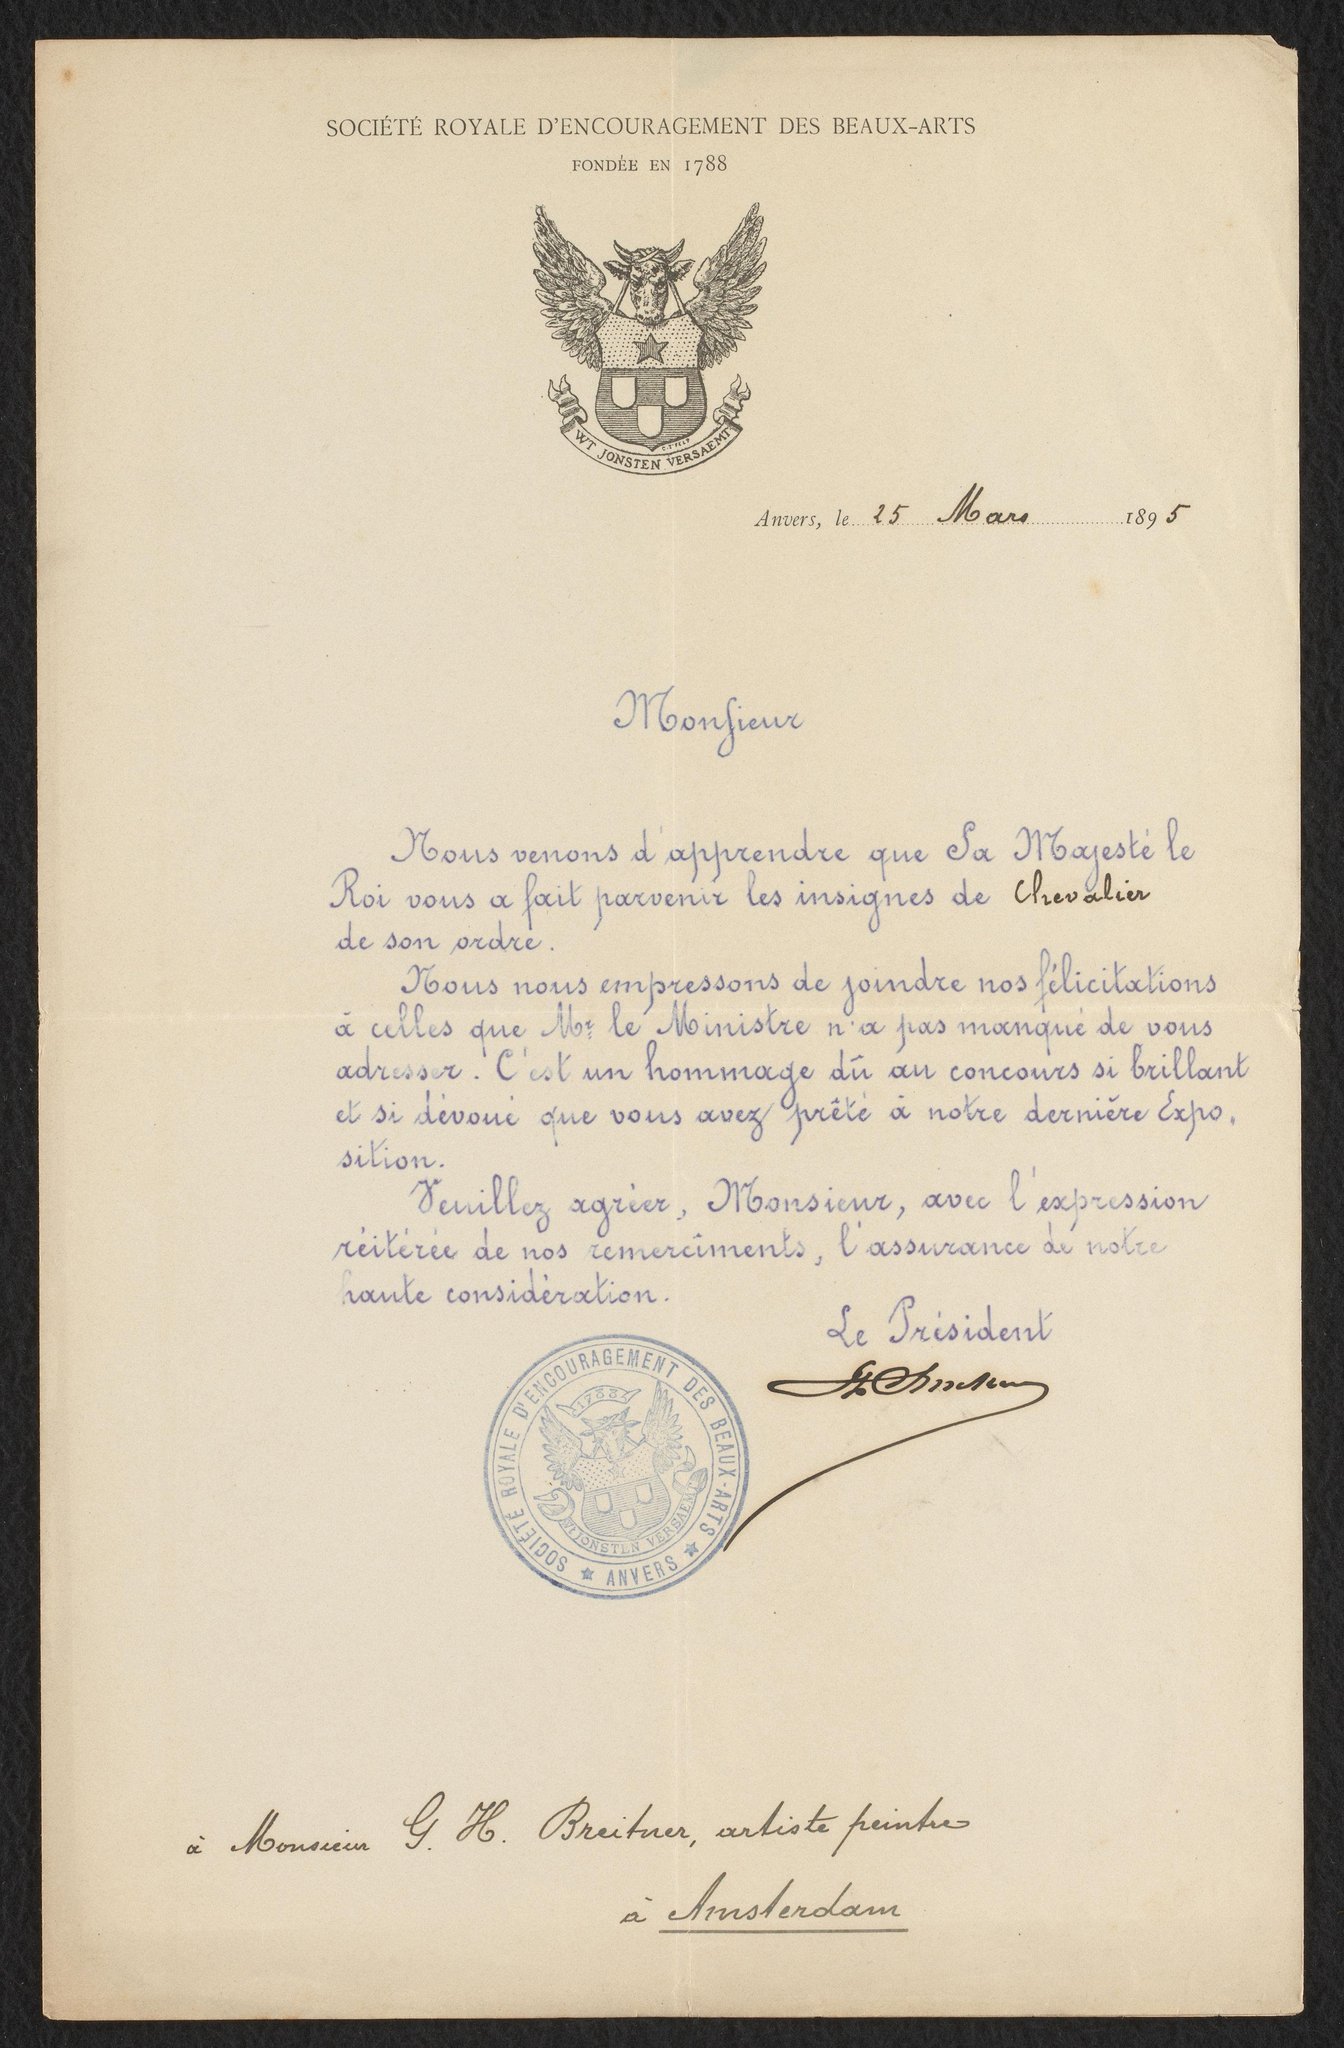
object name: letter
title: Brief gericht aan George Hendrik Breitner betreffende zijn benoeming tot ridder in de Orde van Leopold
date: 1895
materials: ink, paper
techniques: printing, letterpress printing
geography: antwerp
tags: rotterdam, amsterdam, painter, print maker, draughtsman, george hendrik breitner, distribution of awards ~ art contest